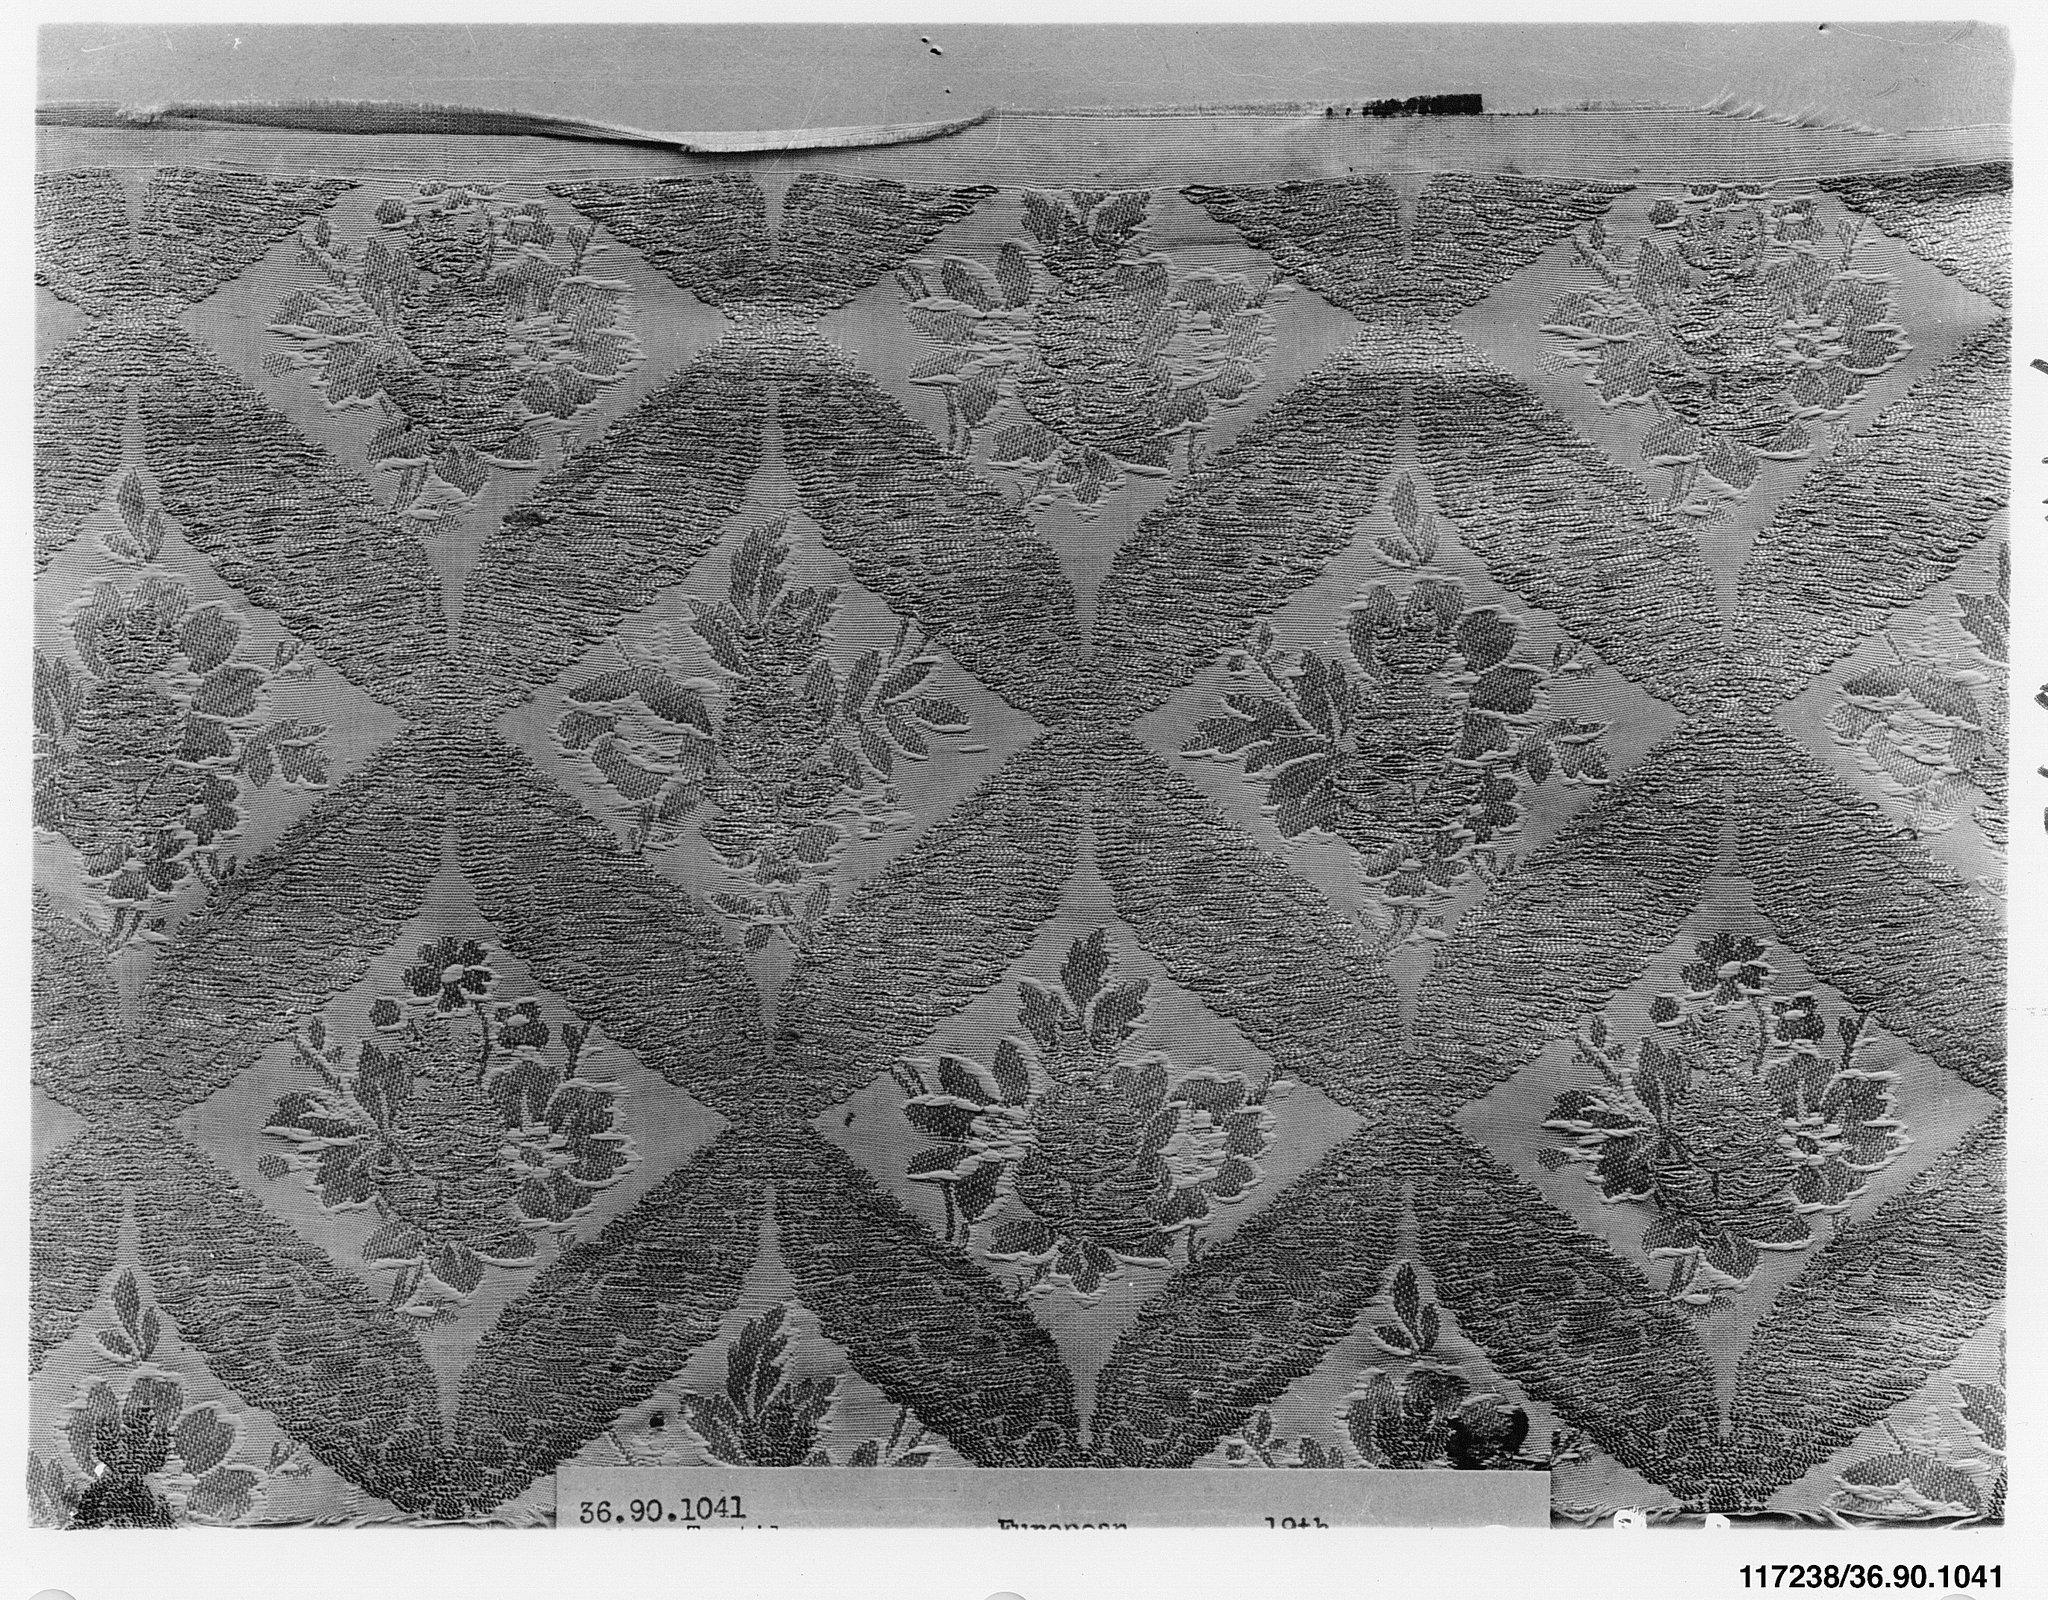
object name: piece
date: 1801-1900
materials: metal thread, silk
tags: flowers,leaves